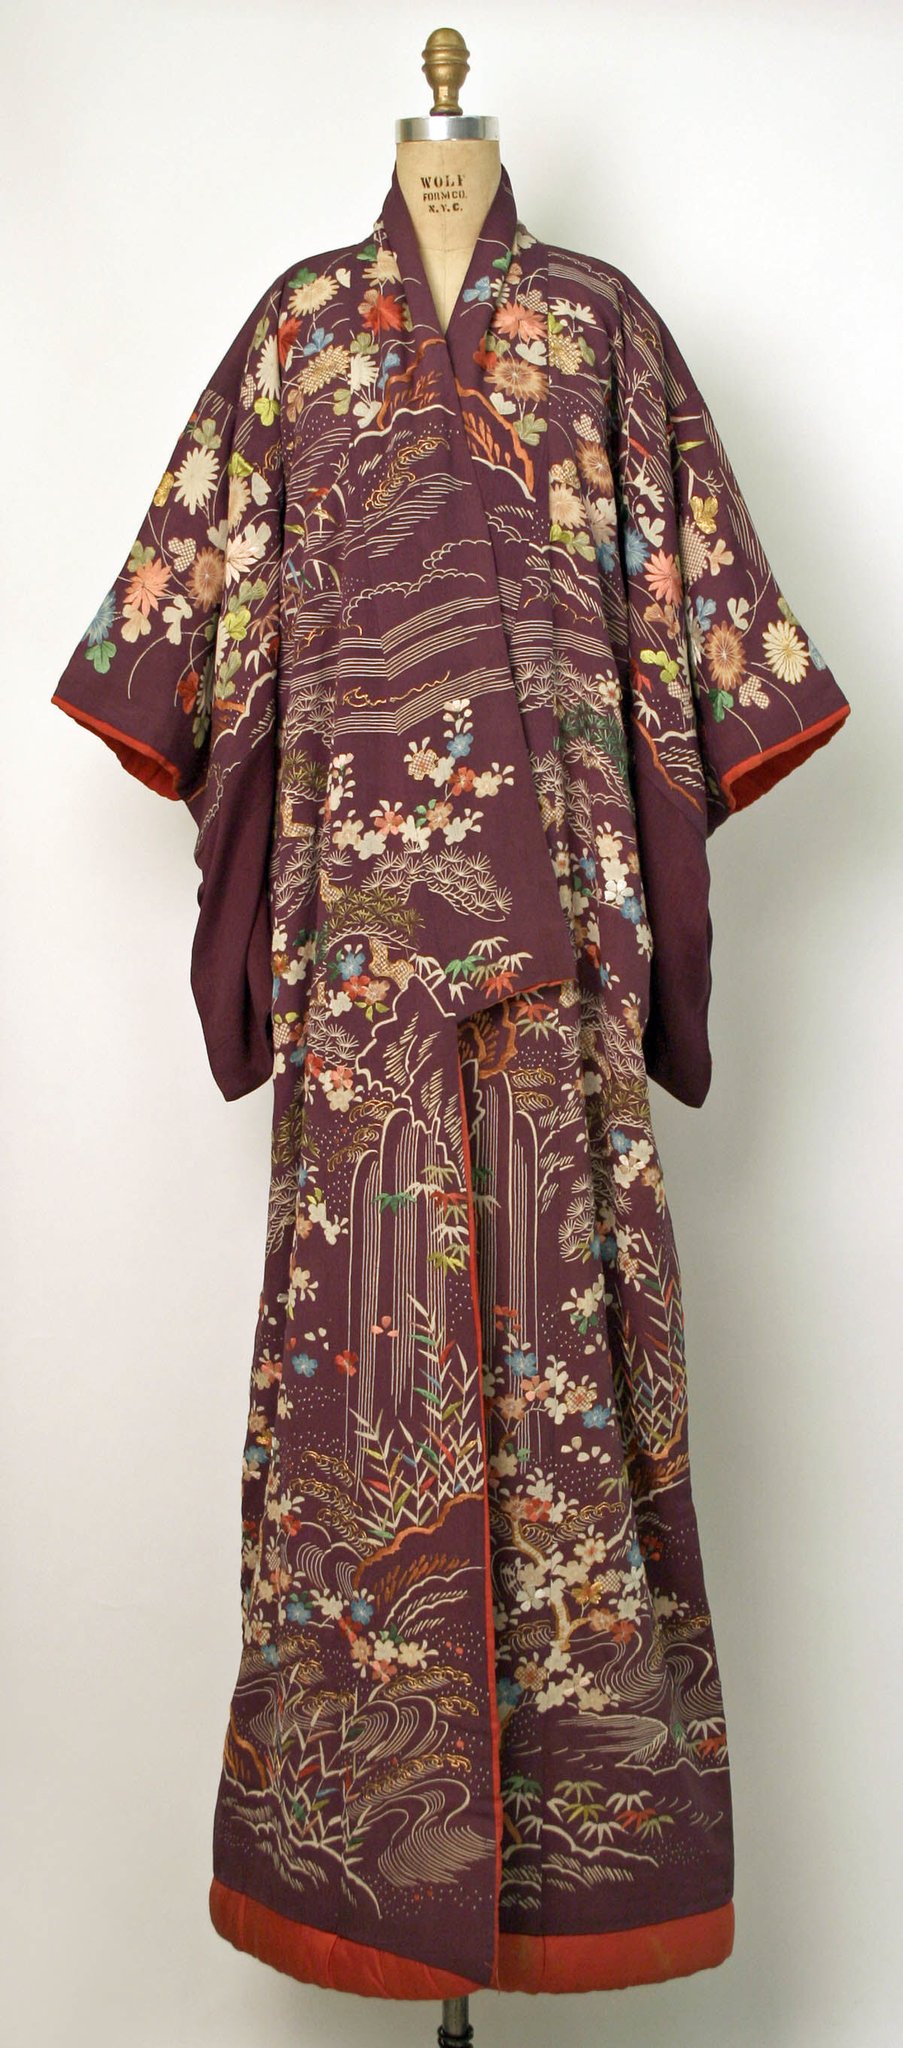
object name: kimono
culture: japanese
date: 1801-1900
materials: silk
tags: flowers